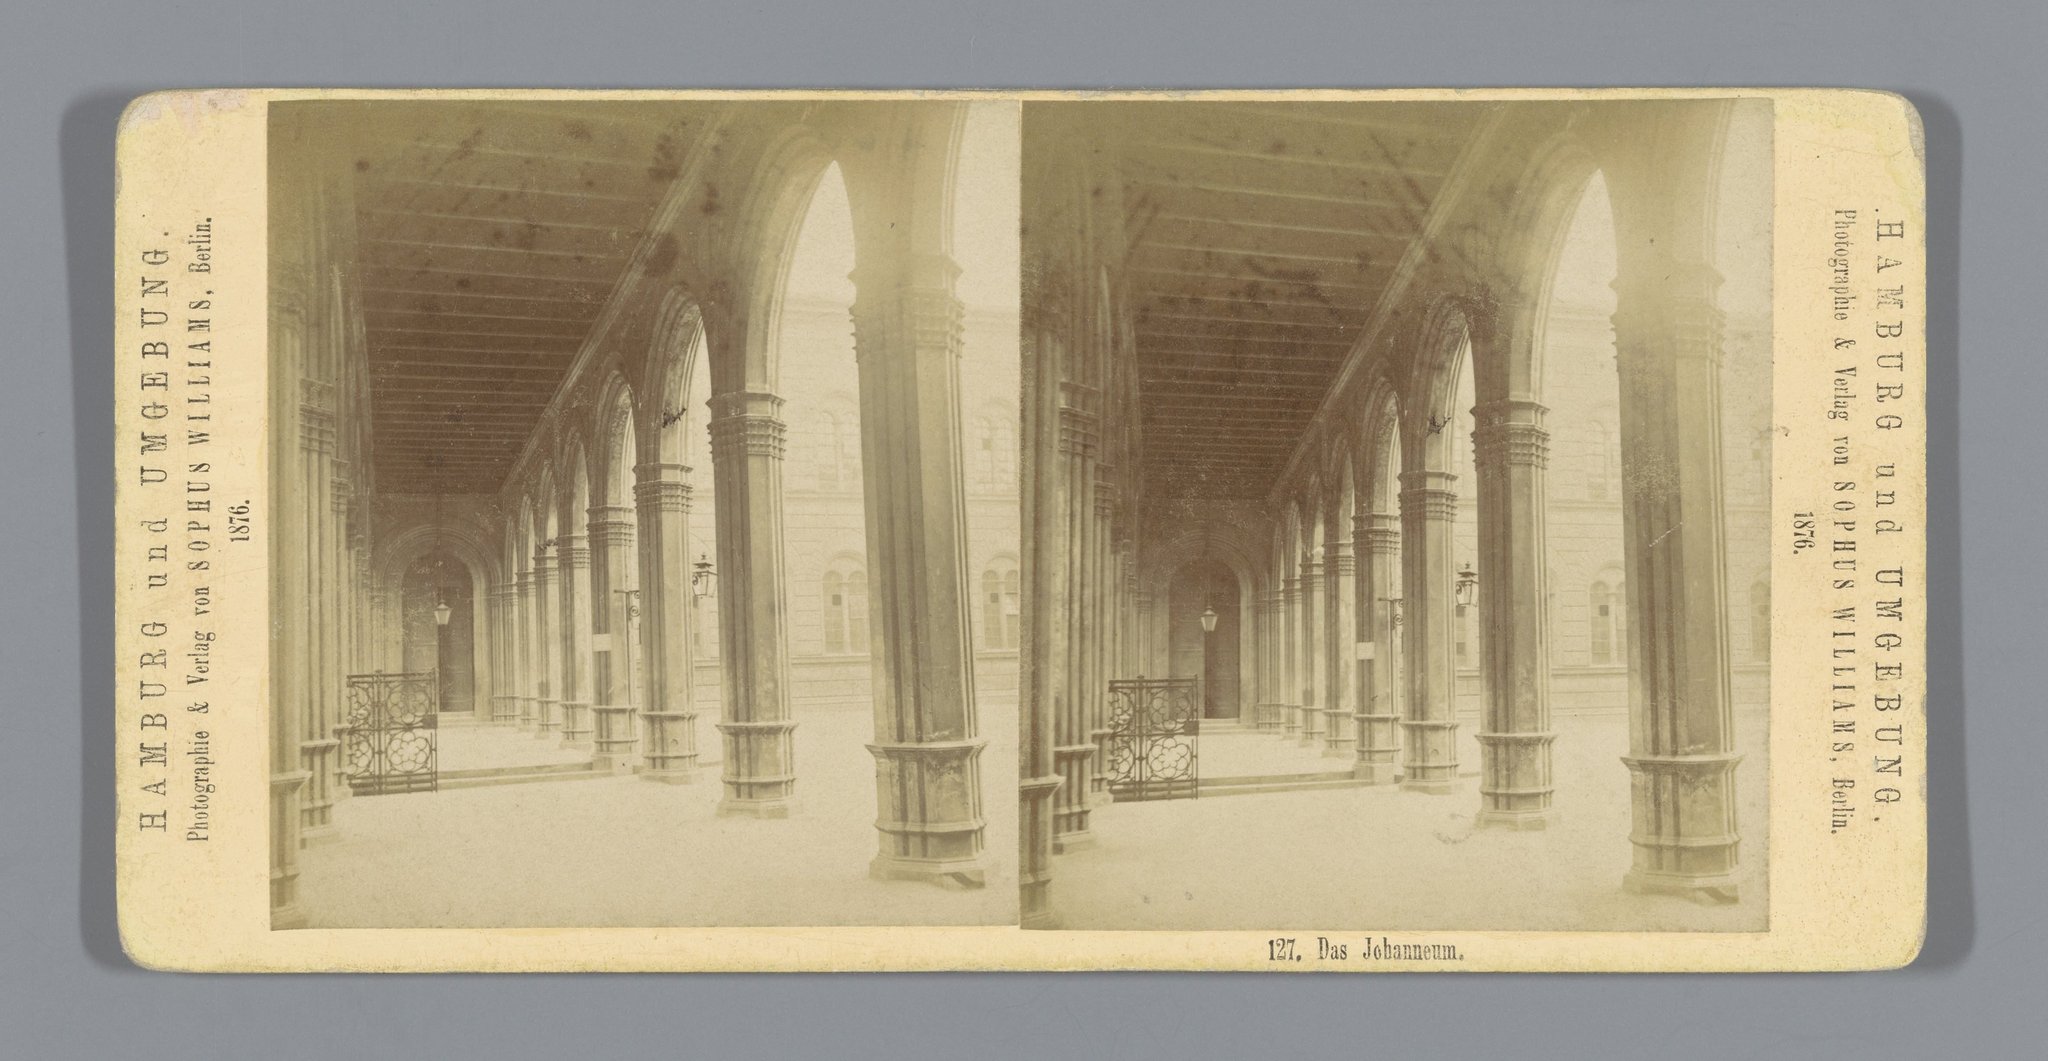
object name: stereograph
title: Das Johanneum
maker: sophus williams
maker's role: publisher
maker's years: 1835-1900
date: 1876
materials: cardboard, photographic support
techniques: albumen print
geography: hamburg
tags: cloisters ~ monastery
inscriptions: number: ‘127.’